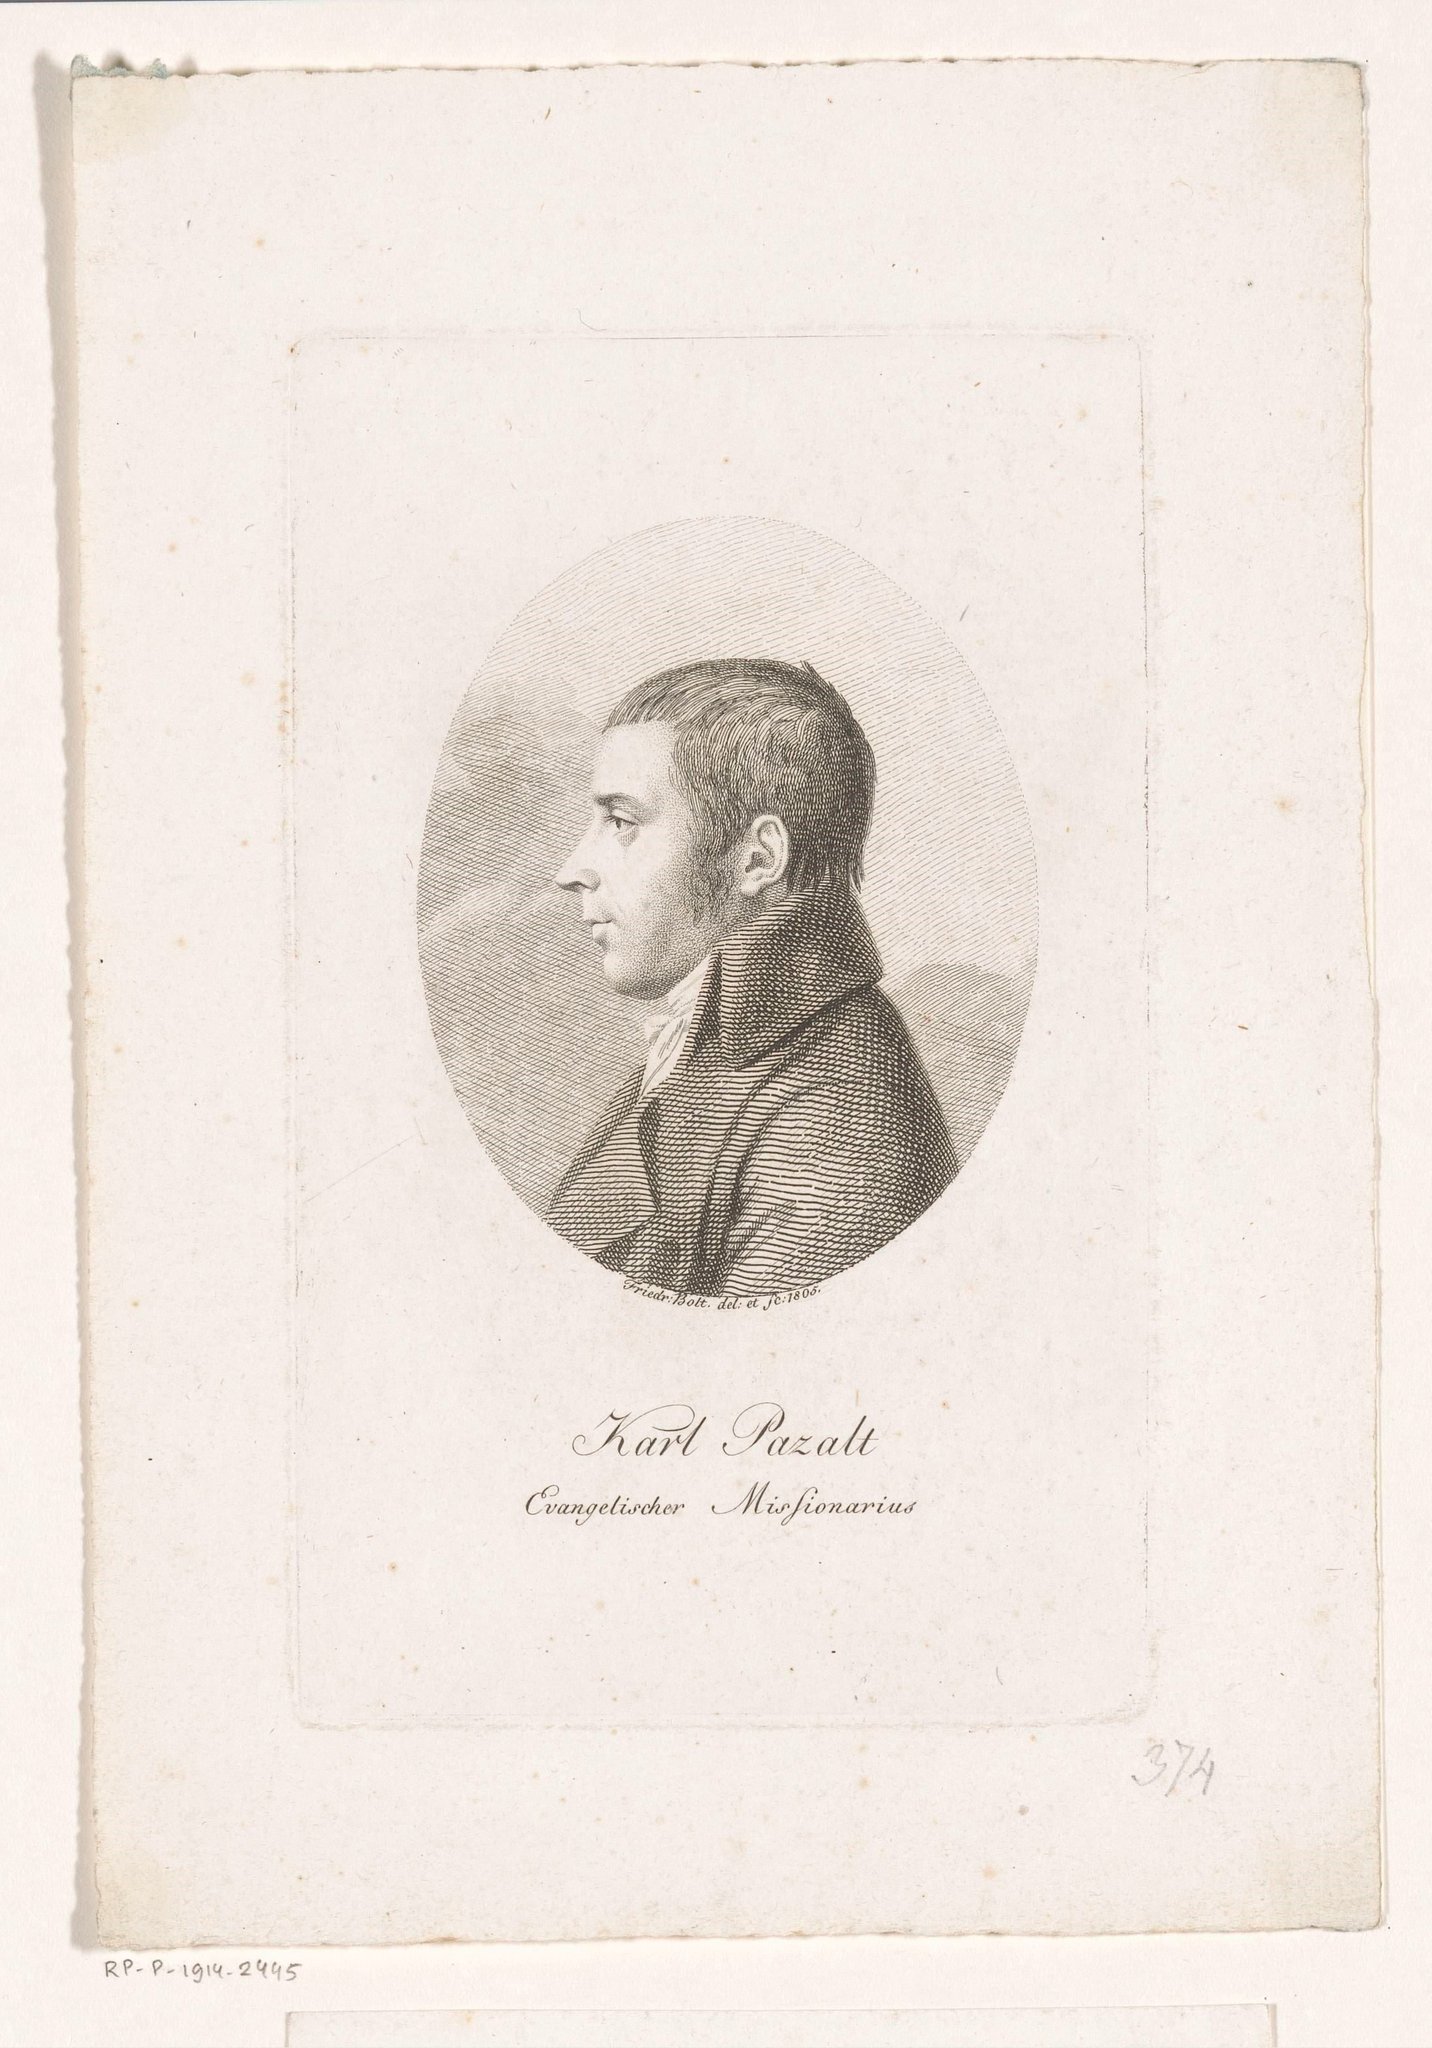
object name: print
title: Portret van Karl August Pácalt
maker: johann friedrich bolt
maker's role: print maker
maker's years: 1769-1836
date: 1805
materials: paper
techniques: engraving, etching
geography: berlin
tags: missionary, historical persons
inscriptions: collector's mark: Lugt 2228